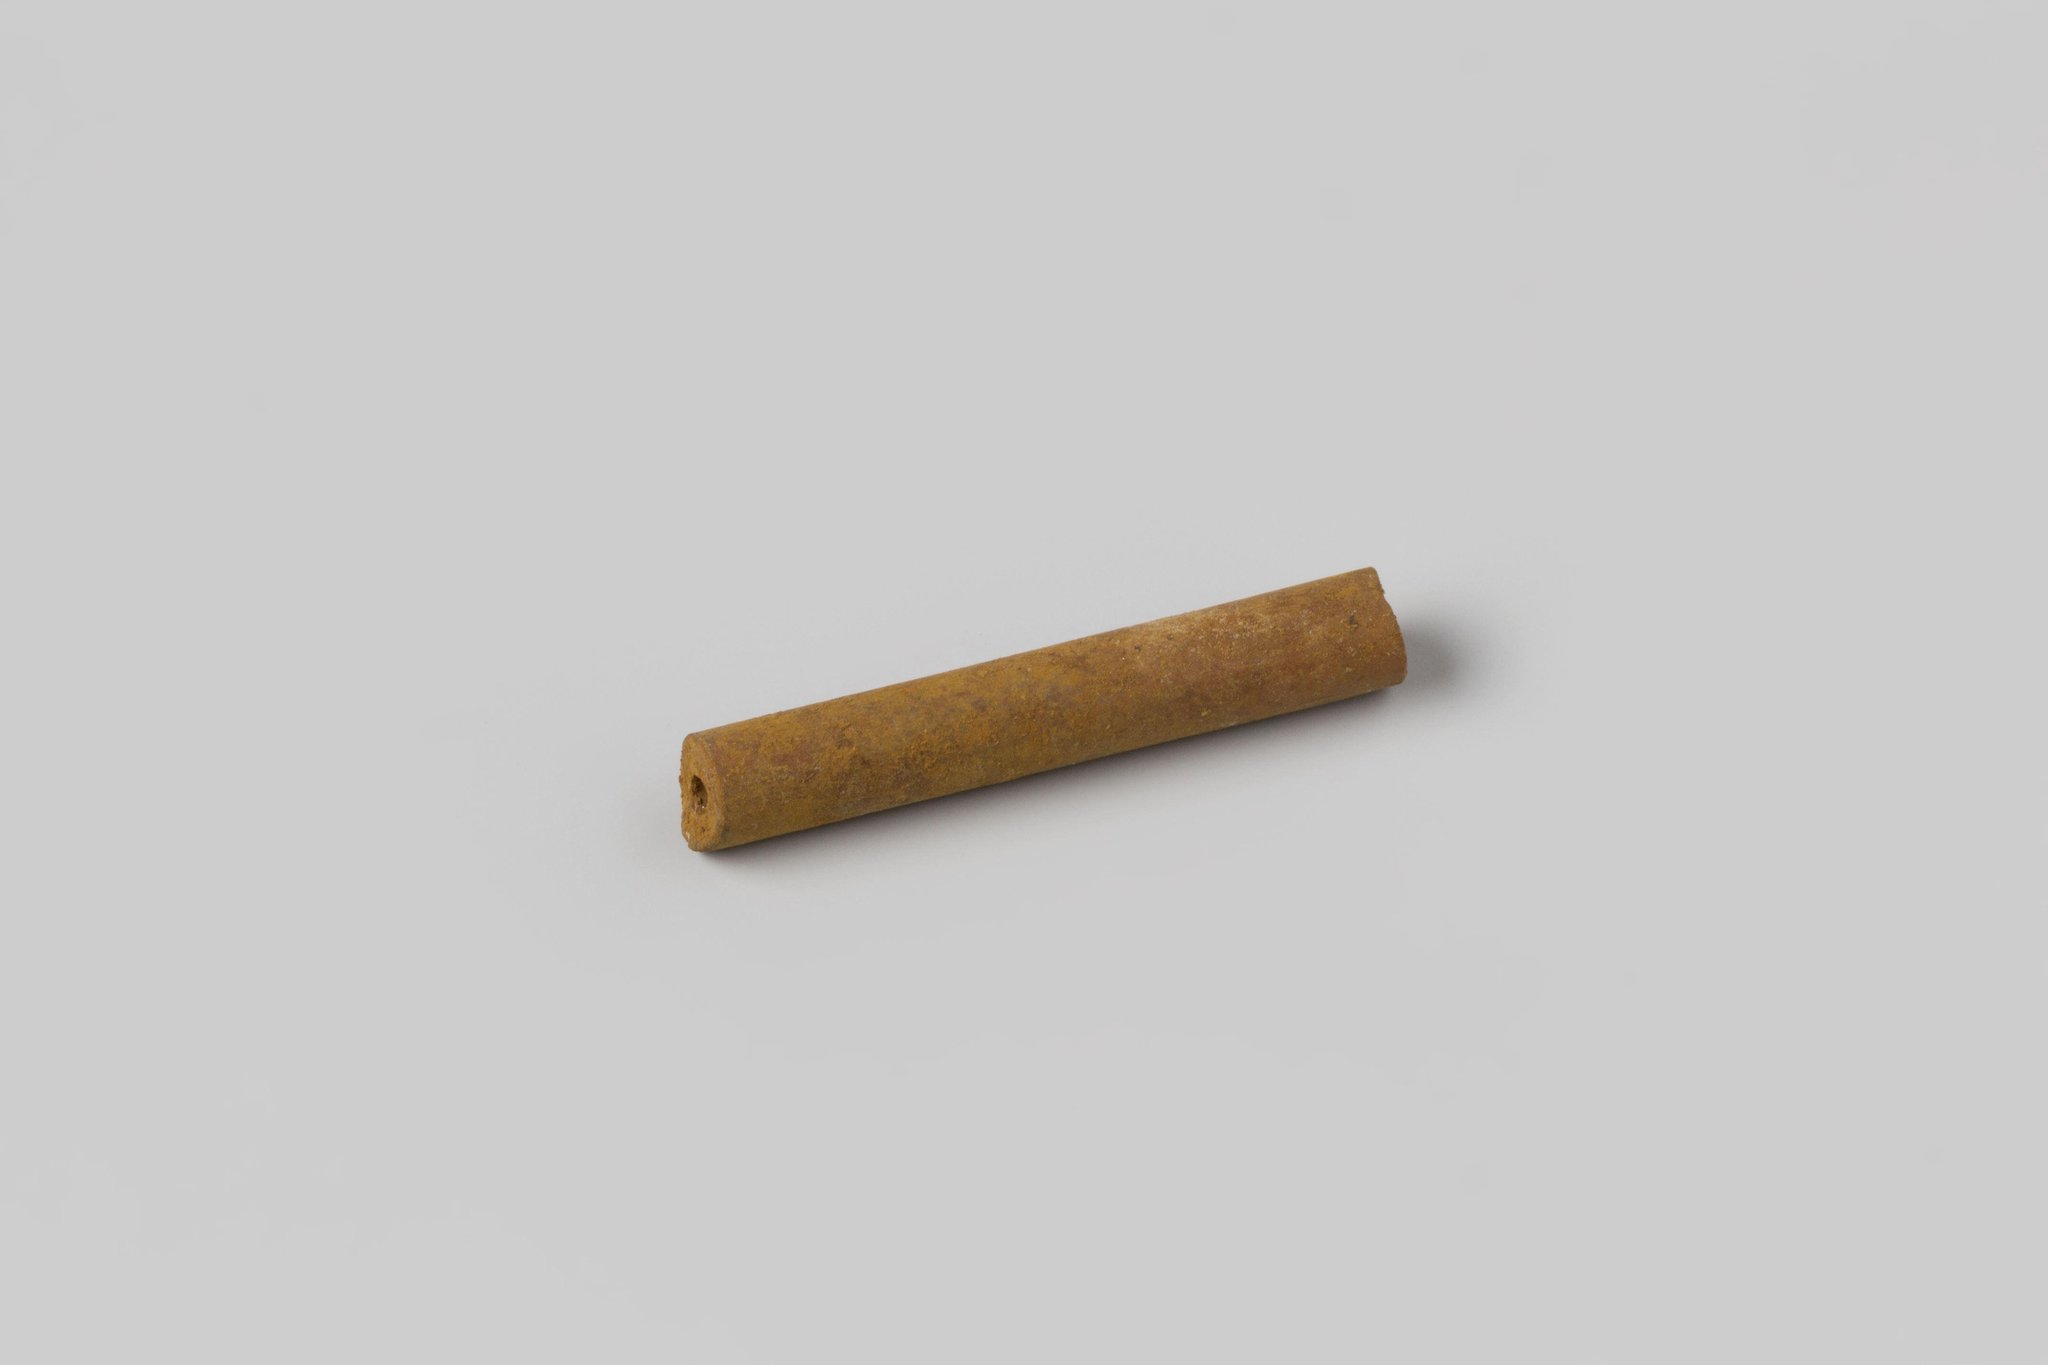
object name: pipe stem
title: Fragment pijpensteel uit het wrak van de Oost-Indiëvaarder Hollandia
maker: Anonymous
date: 1700-1743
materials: clay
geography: netherlands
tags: verenigde oostindische compagnie, hollandia (schip), annet